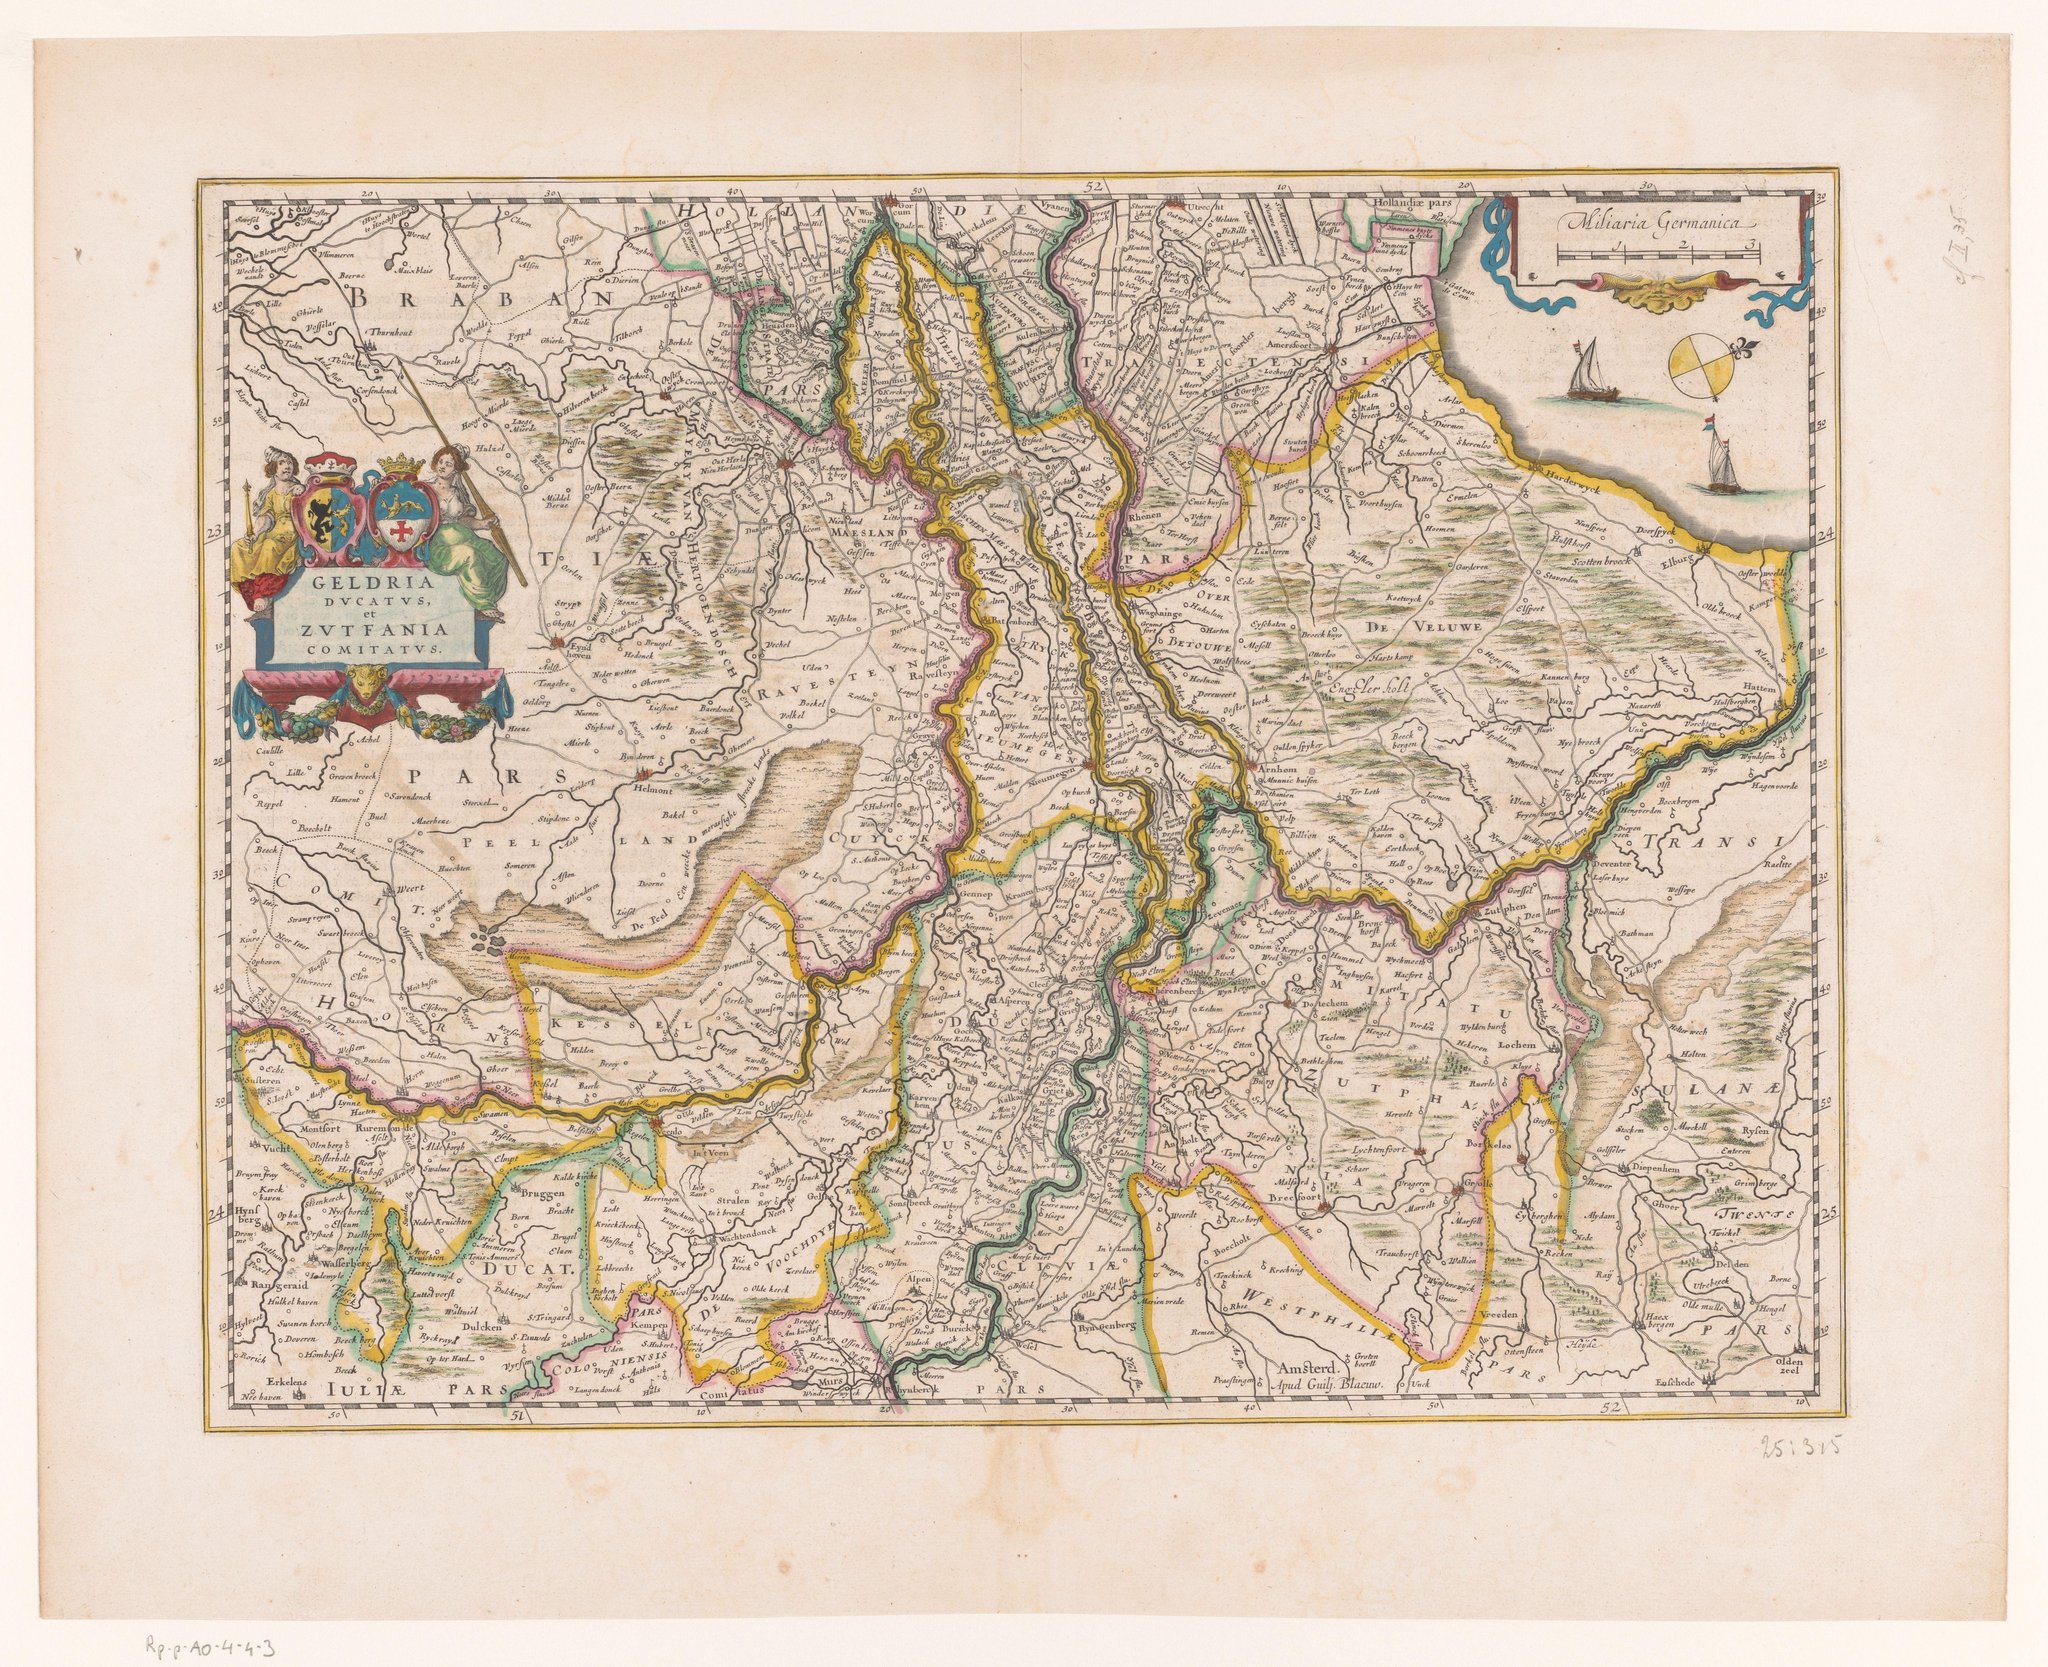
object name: map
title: Geldria ducatus, et Zutfania comitatus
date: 1647-1664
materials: paper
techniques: engraving, etching, hand coloring, letterpress printing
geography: amsterdam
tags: coat of arms (as symbol of the state, etc.) (+ city; municipal), maps of separate countries or regions, coat of arms (as symbol of the state, etc.) (+ province; provincial), gelderland, guelders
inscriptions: collector's mark: Lugt 2228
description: Prent gebruikt in: Blaeu, Willem Janszoon en Johannes Willemszoon Blaeu. Toonneel des aerdrycx, ofte nieuwe Atlas, dat is de beschryving van alle landen. 4 delen. Amsterdam: Johannes Willemszoon Blaeu, 1647-1650, dl. 1 (1647-1648). Of in: Blaeu, Johannes Willemszoon. J. Blaeus grooten atlas oft wereltbeschyving, in welcke 't aerdryck, de zee, en hemel, wort vertoont en beschreven. 9 delen. Amsterdam: Johannes Willlemszoon Blaeu, 1664-1665, dl. 3 (1664).